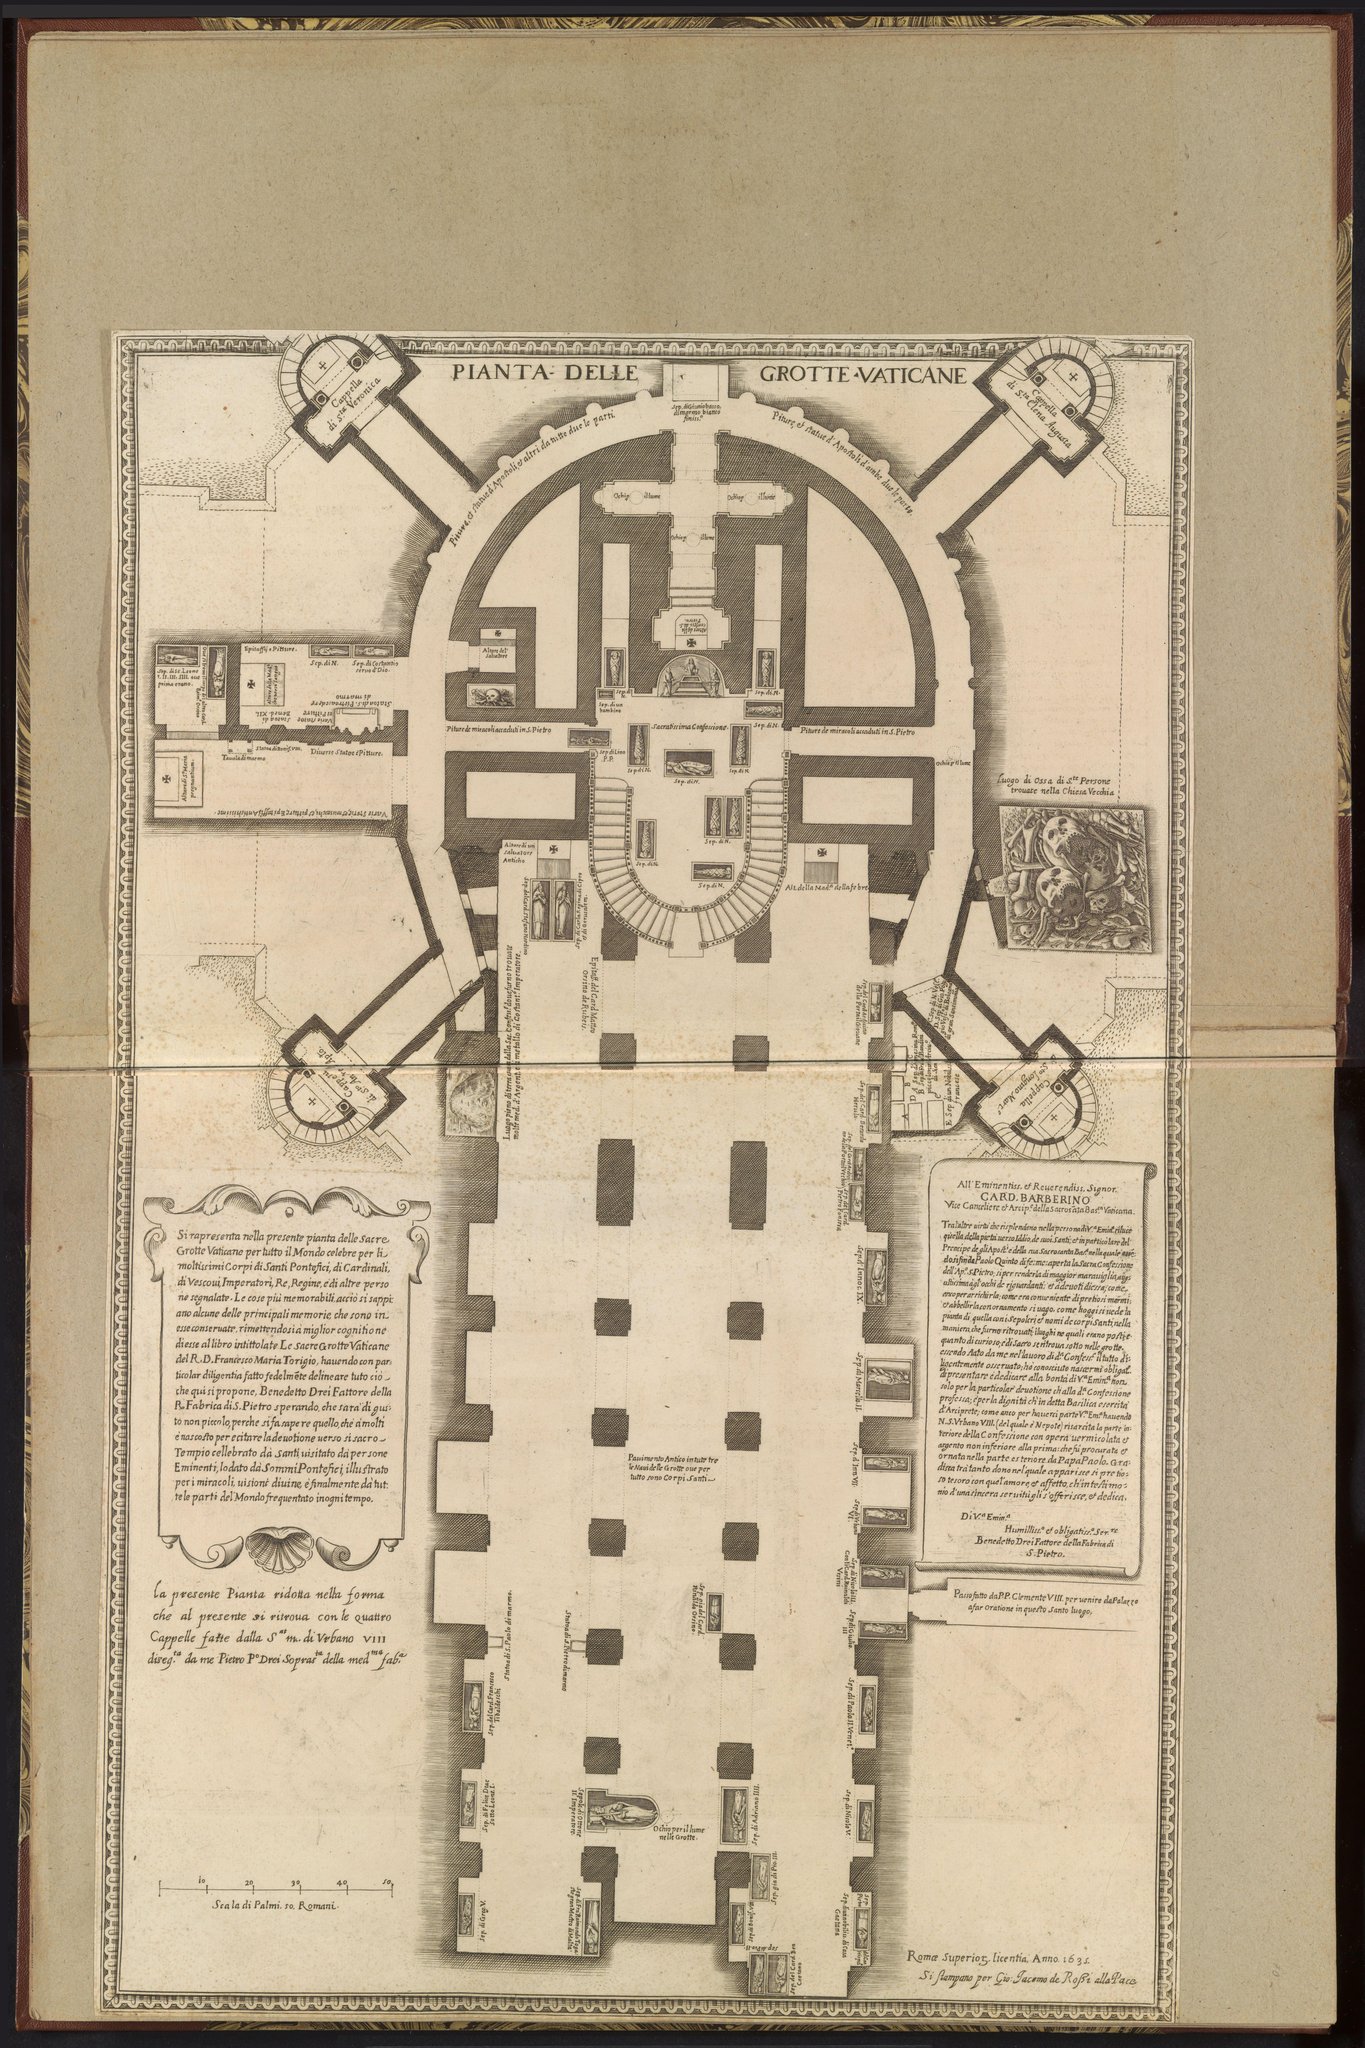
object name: album leaf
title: Pianta delle grotte Vaticane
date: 1635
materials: paper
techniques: etching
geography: italy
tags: rome, sixtus v, roman catholic church, parts of church interior (crypt), plan ~ architecture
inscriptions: date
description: Plattegrond van de crypte onder de Sint-Pietersbasiliek te Vaticaanstad. Links een cartouche met tekst in het Italiaans. Rechts een tekstrol met een opdracht in het Italiaans. De prent maakt deel uit van een album.